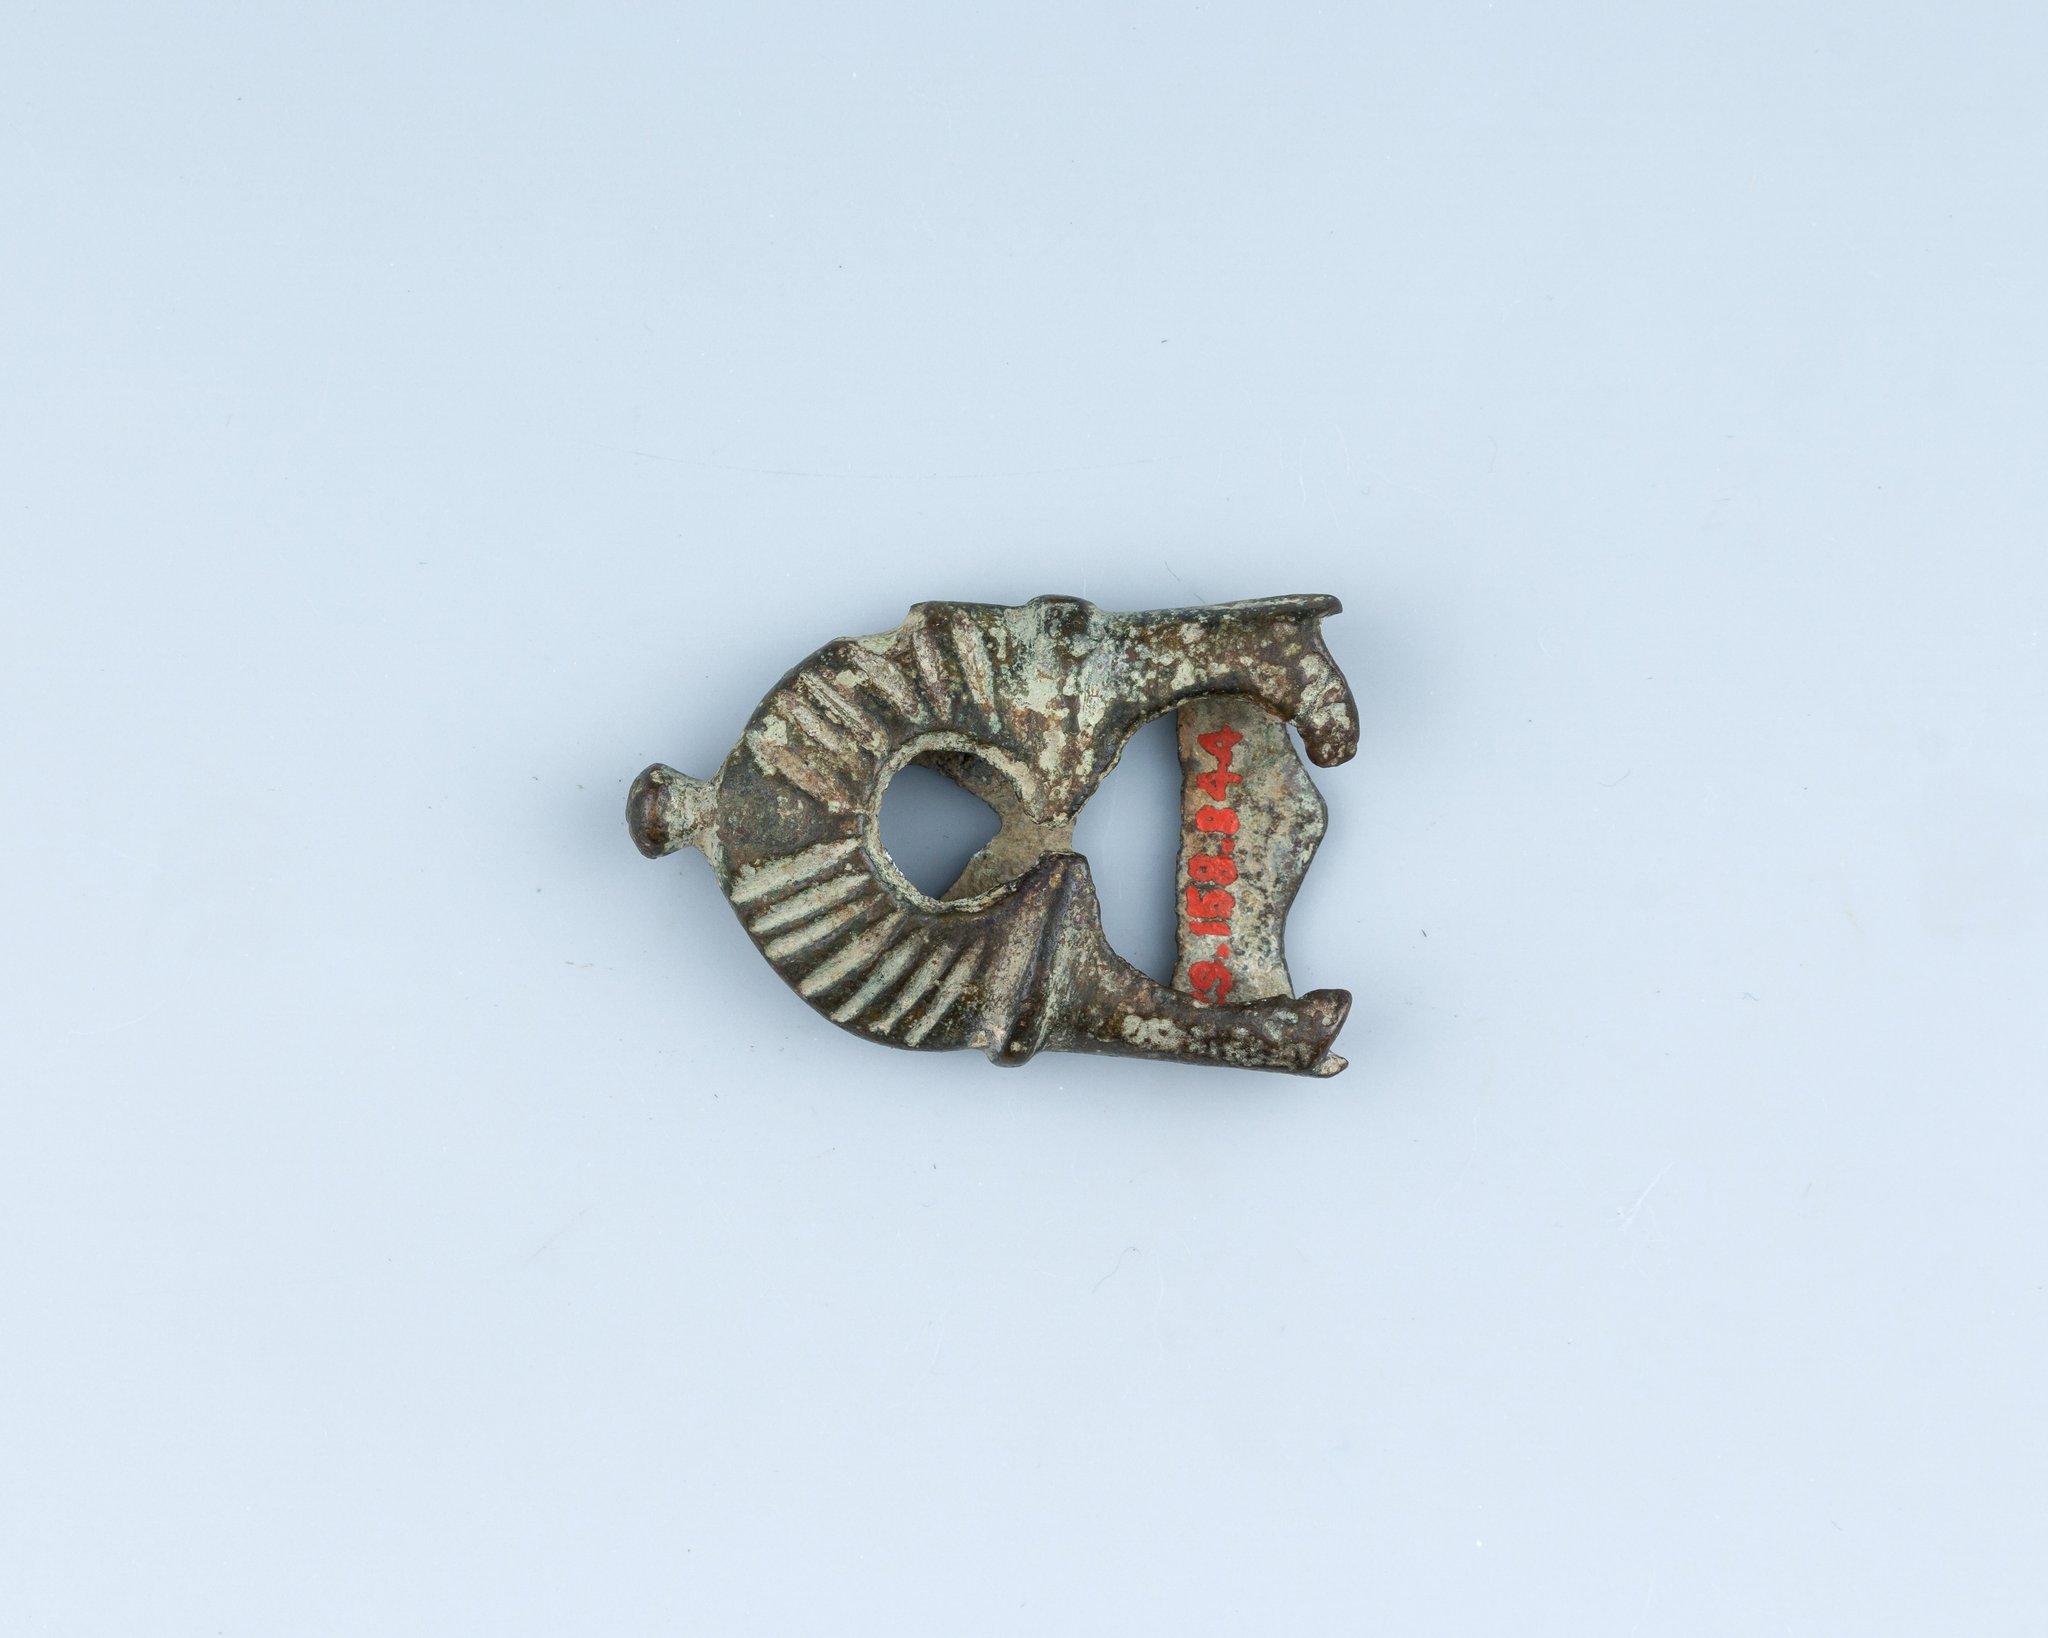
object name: mordant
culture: european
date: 1401-1700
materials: bronze